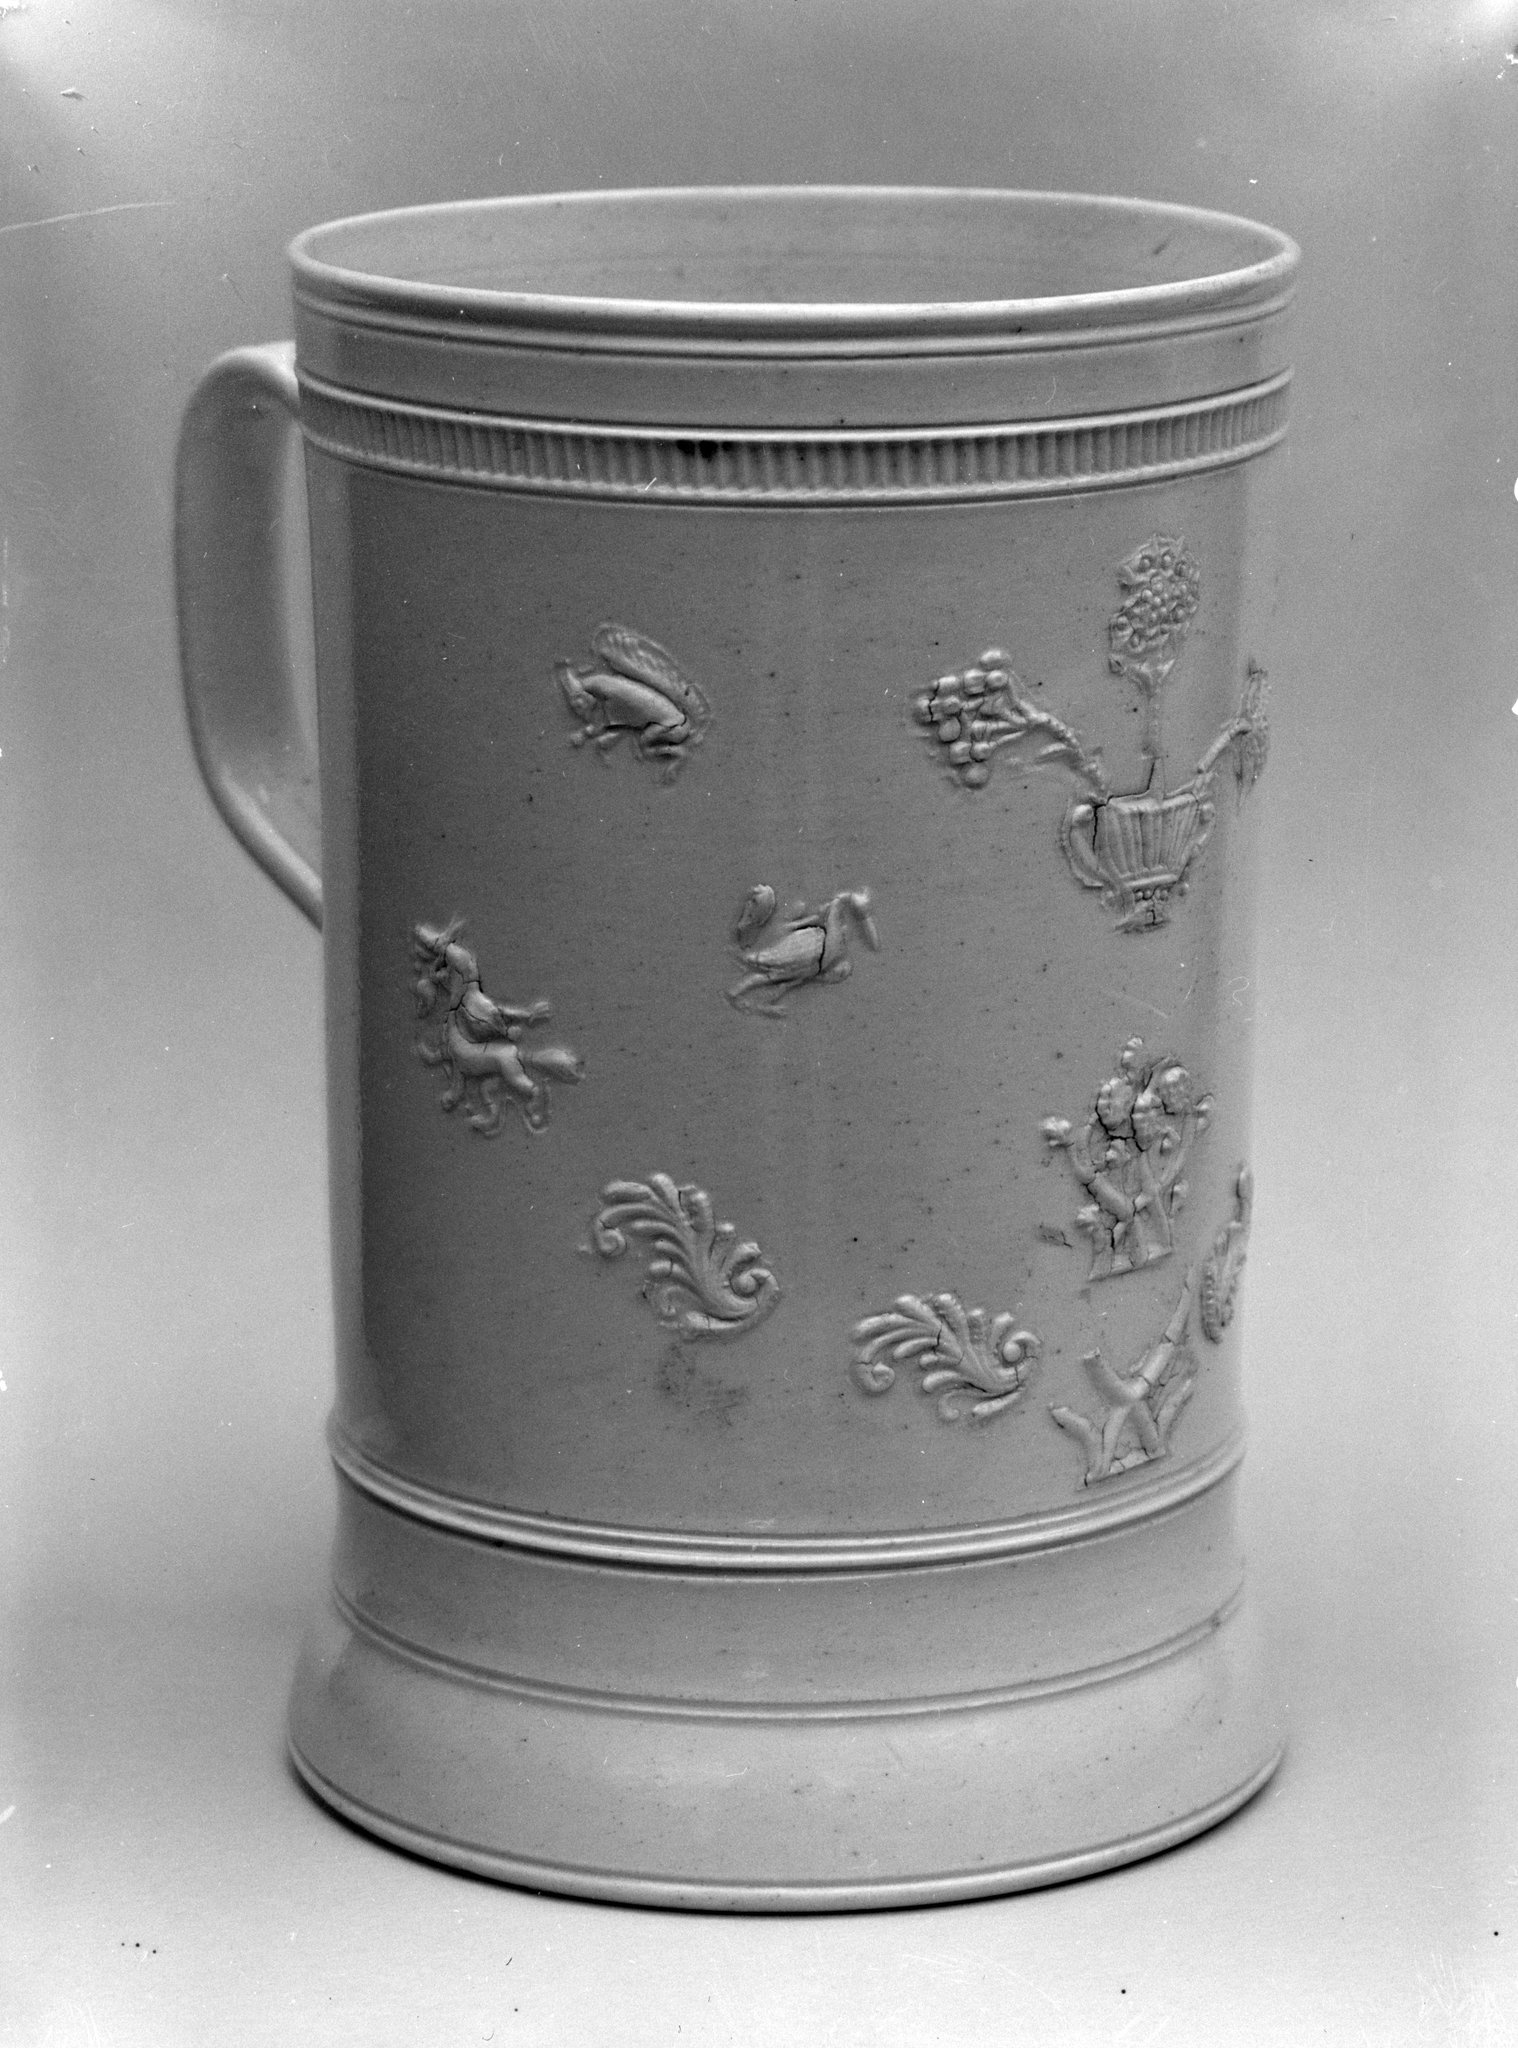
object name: mug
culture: british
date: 1740-1760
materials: stoneware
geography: england